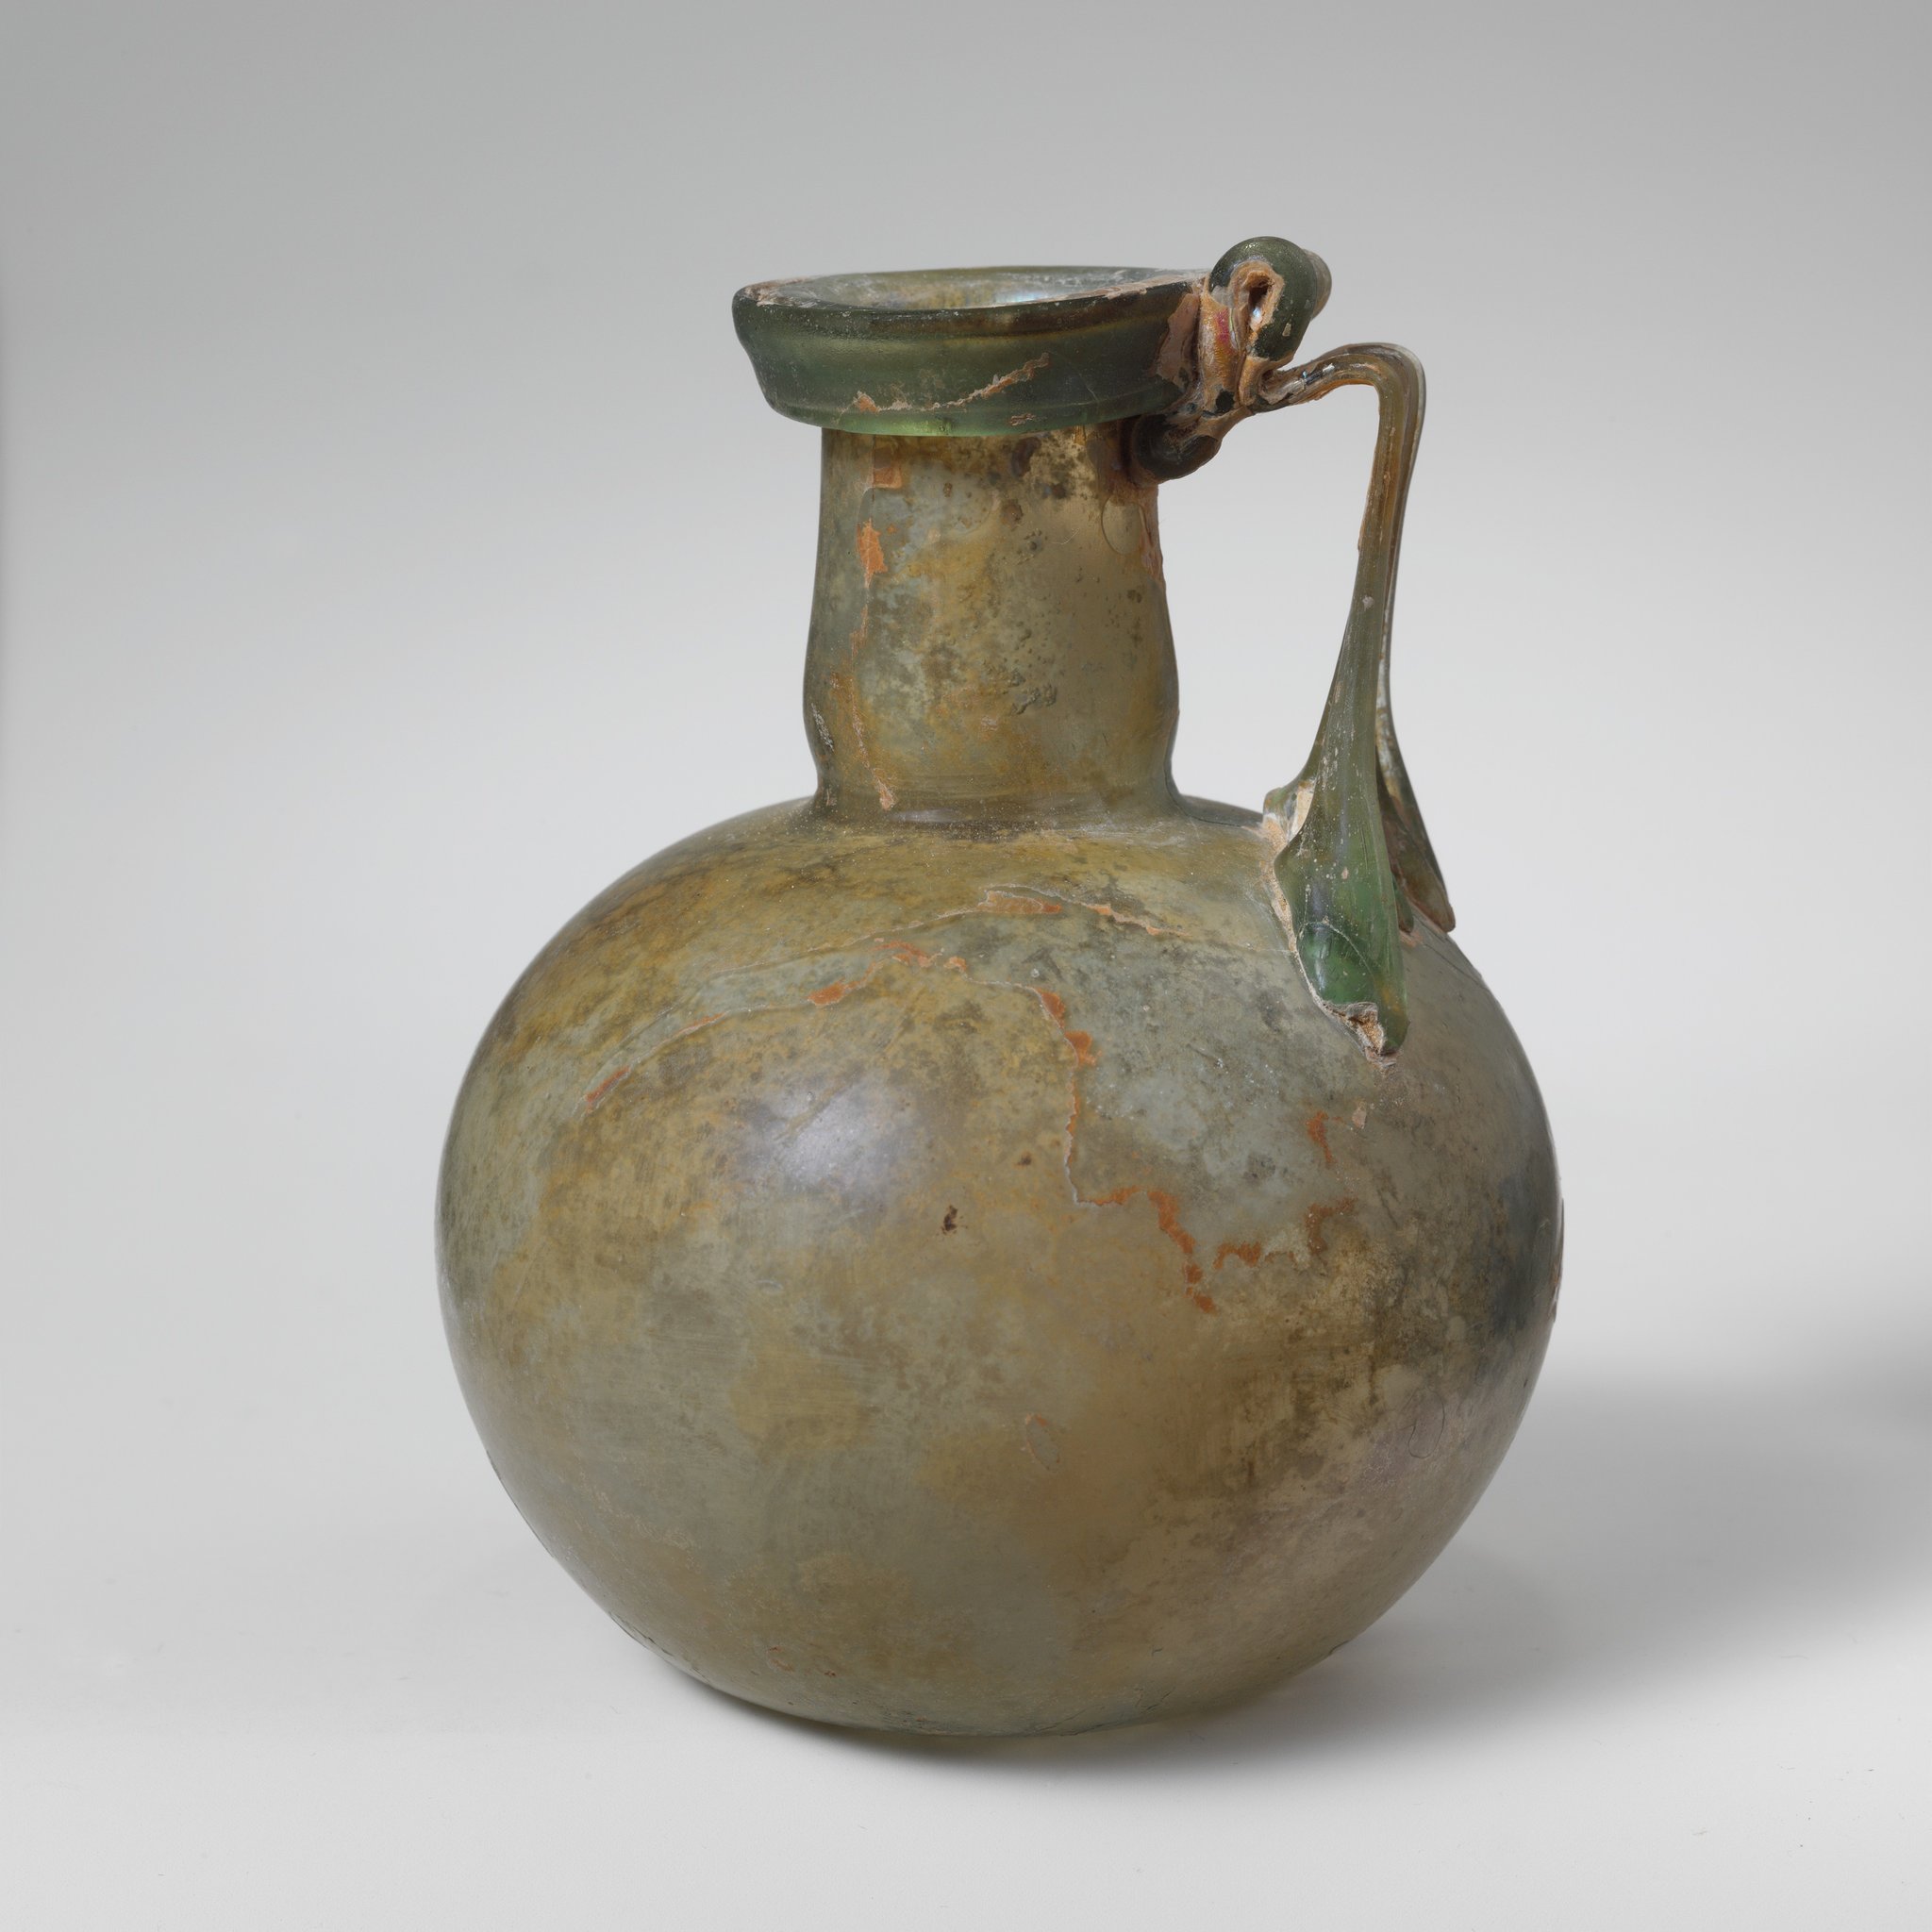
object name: jug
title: Glass jug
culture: roman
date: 34-200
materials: glass